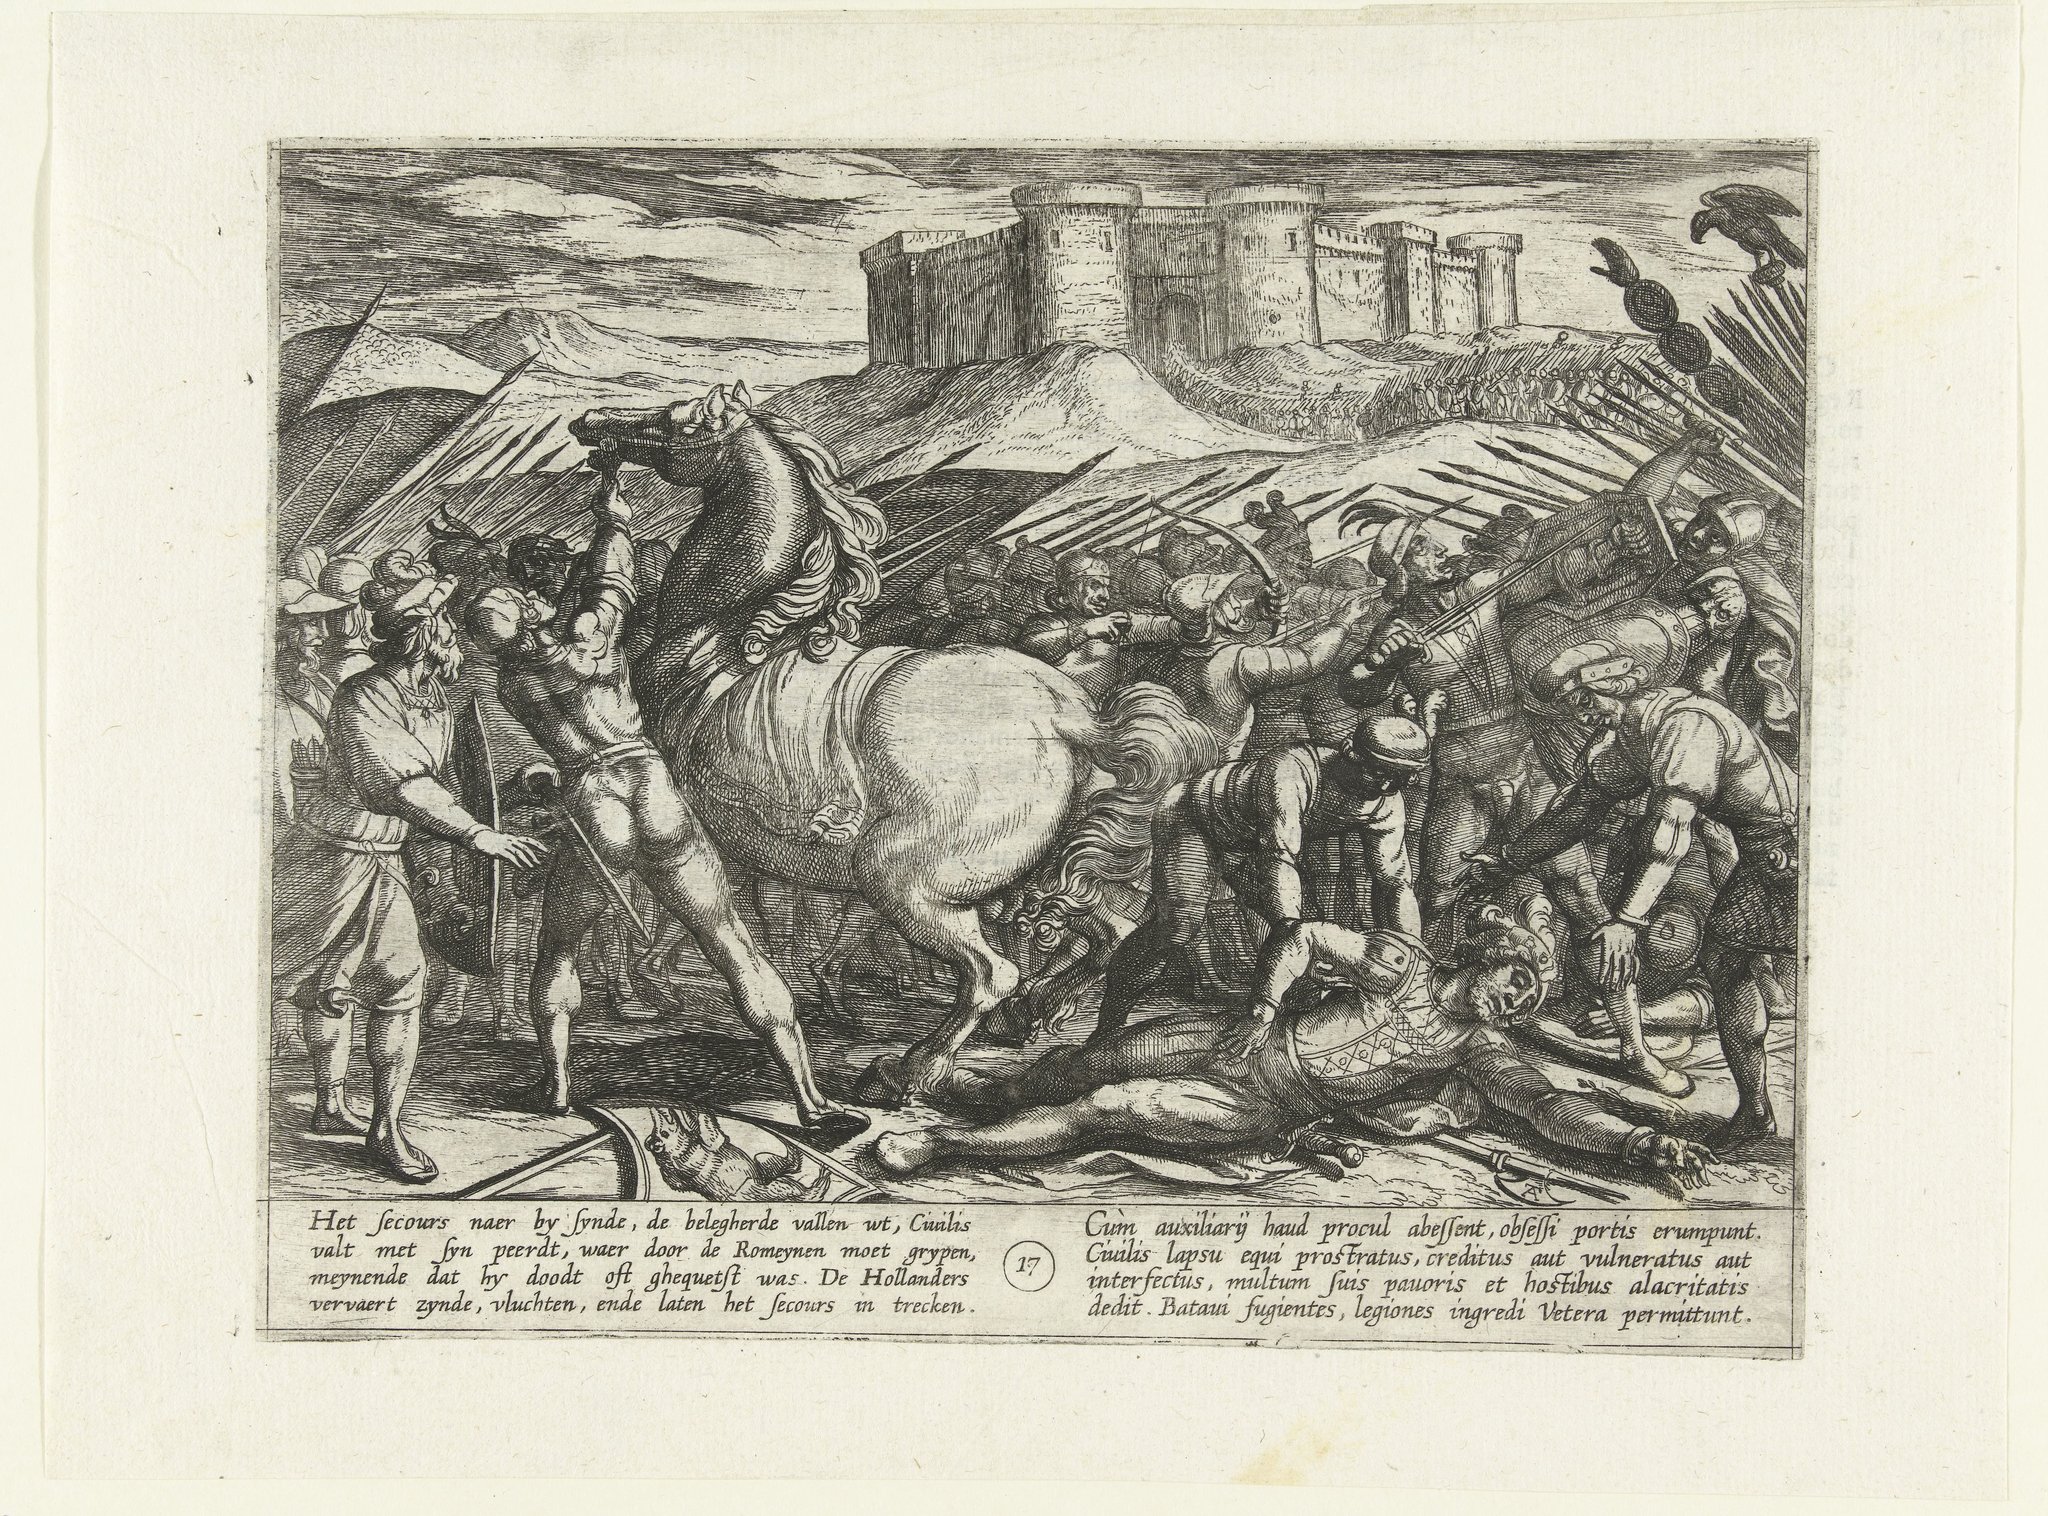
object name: history print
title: Batavorum cum Romanis Bellum, à Corn. Tacito / De Batavische Oft Oude Hollandtsche Oorloghe teghen de Romeynen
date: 1612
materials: paper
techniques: etching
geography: italy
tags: battle, fighting in general, extinct, 'historical' peoples (with name), netherlands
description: Civilis valt van zijn paard om de Romeinen te misleiden en te laten denken dat hij dood of gewond is. Prent nummer 17 in de serie prenten over de Bataafse Opstand: Batavorum cum Romanis bellum / à Corn. Tacito lib. IV & V. : Hist. olim descriptum, figuris nunc aeneis expressum, auctore Othone Vaenio Lugdunobatava = De Batavische oft oude Hollandtsche oorloghe teghen de Romeynen. Otto Vaenius, Antwerpen 1612. Onderaan twee verzen van vier regels in het Nederlands en in het Latijn. Op de achterzijde tekst in het Latijn.